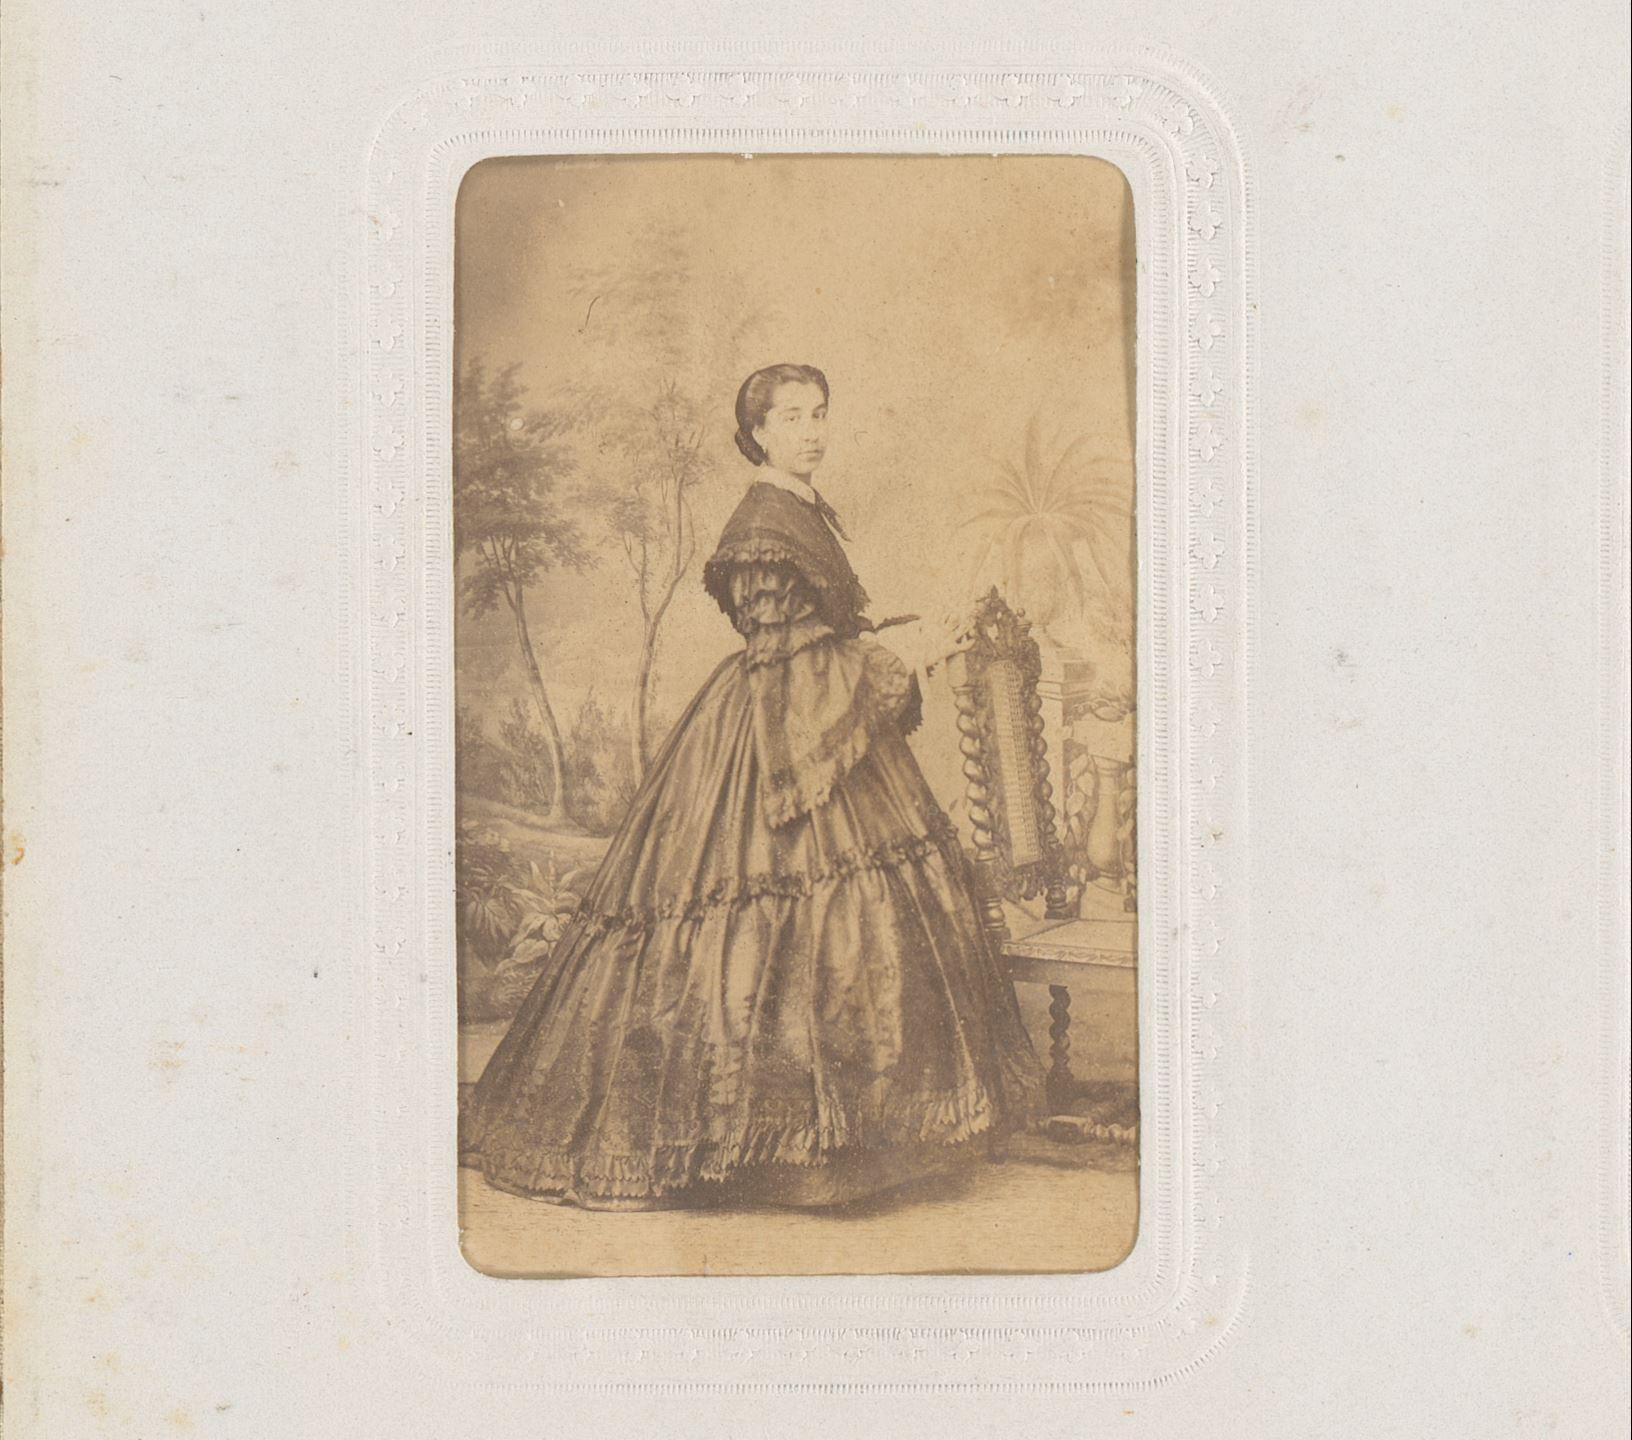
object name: carte de visite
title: Portret van een vrouw, staand bij een stoel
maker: josé martínez sanchez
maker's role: fotograaf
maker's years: 1807-1874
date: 1850-1874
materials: cardboard, photographic support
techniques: albumen print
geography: madrid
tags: historical persons - bb - woman, standing figure - aa - female human figure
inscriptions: inscription: ‘Fotografia/ de J. Martinez Sanchez/ 1 y 3 Puerta del Sol’